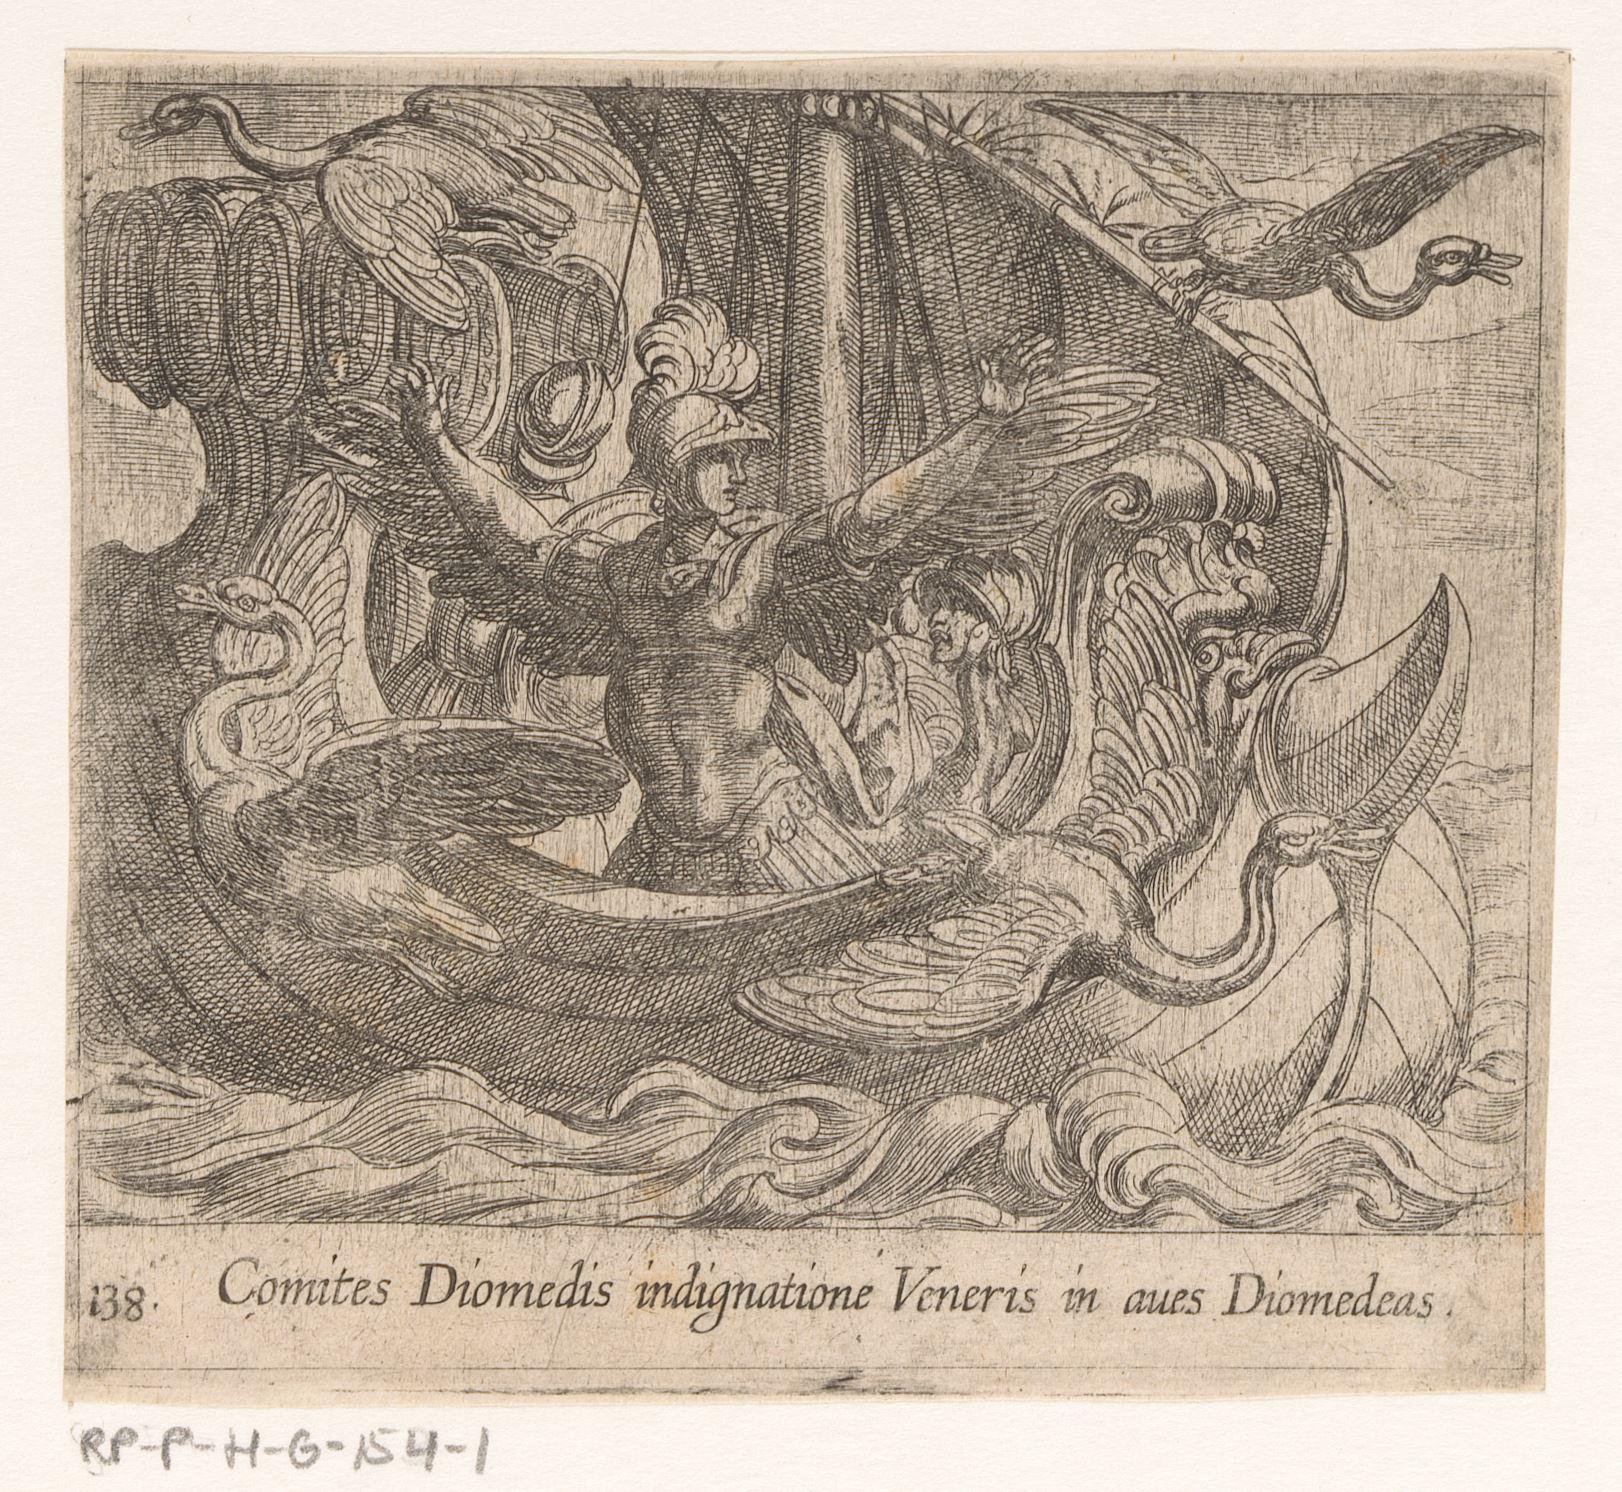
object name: print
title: De metgezellen van Diomedes in reigers veranderd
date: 1606-1638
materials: paper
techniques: etching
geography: amsterdam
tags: diomedes' companions changed into herons: because they have insulted her, venus changes diomedes' companions into herons (ovid, metamorphoses xiv 494)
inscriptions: collector's mark: ‘Hinloopen’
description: De metgezellen van Diomedes staan op een schip op zee en worden door Venus in reigers veranderd. Titel in het Latijn in ondermarge.